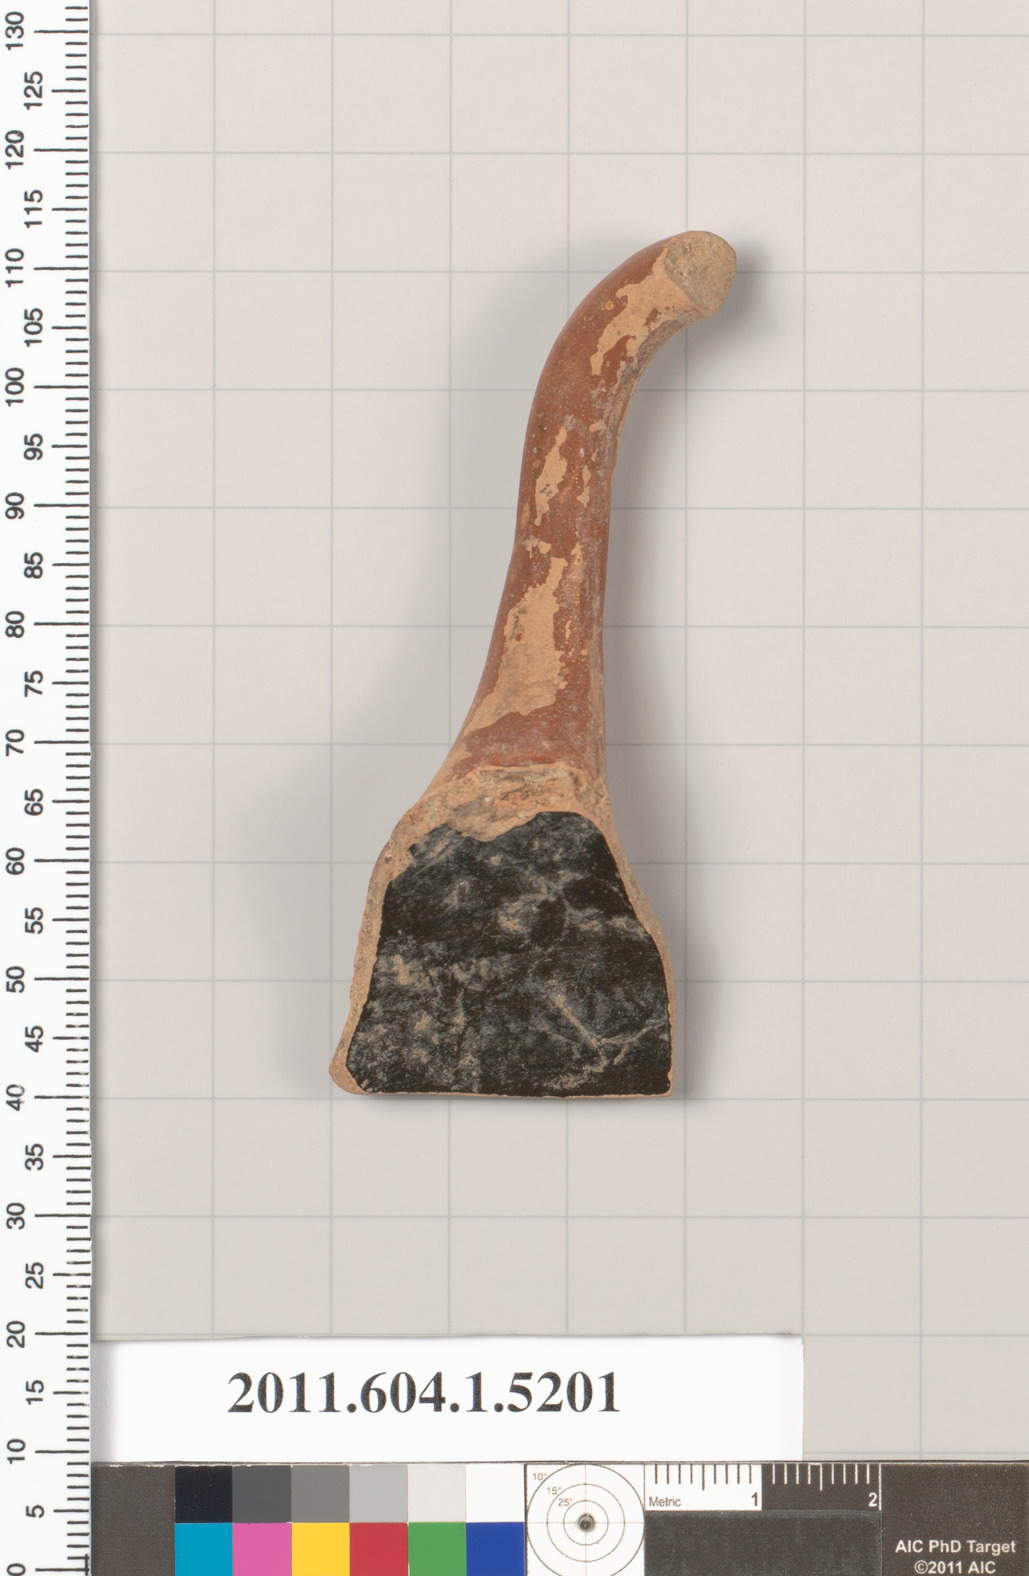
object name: kylix fragment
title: Terracotta fragment of a kylix (drinking cup)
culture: greek, attic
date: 500-451 BCE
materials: terracotta